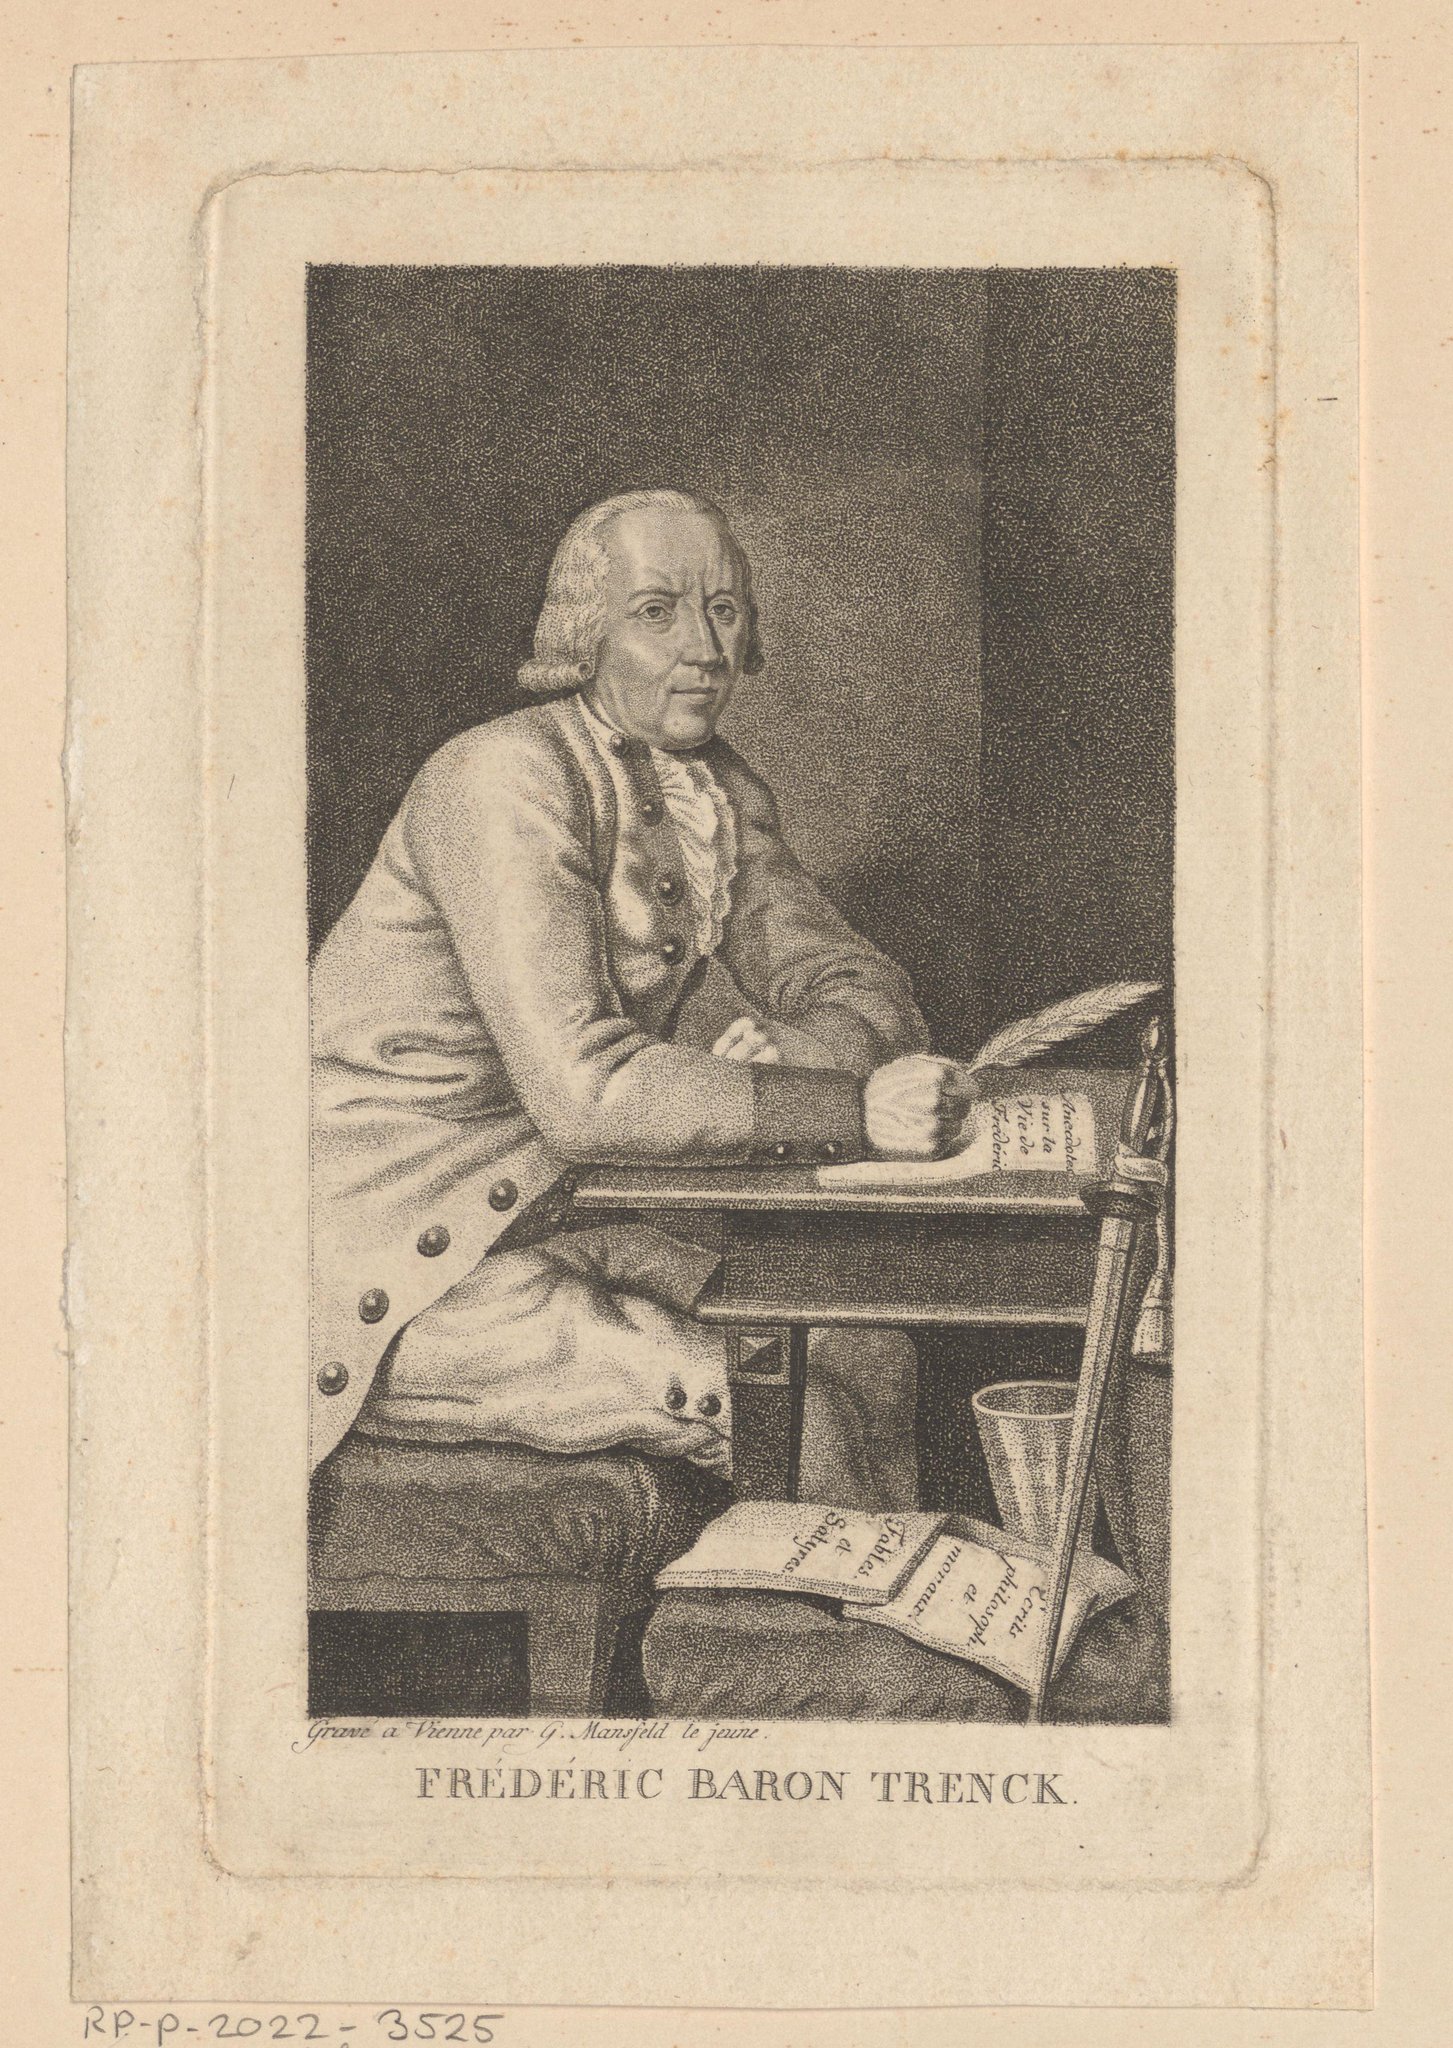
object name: print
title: Portret van Friedrich von der Trenck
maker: johann georg mannsfeld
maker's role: print maker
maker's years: 1764-1817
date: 1774-1817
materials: paper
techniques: etching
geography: vienna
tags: writing tools, historical persons, portrait of a writer